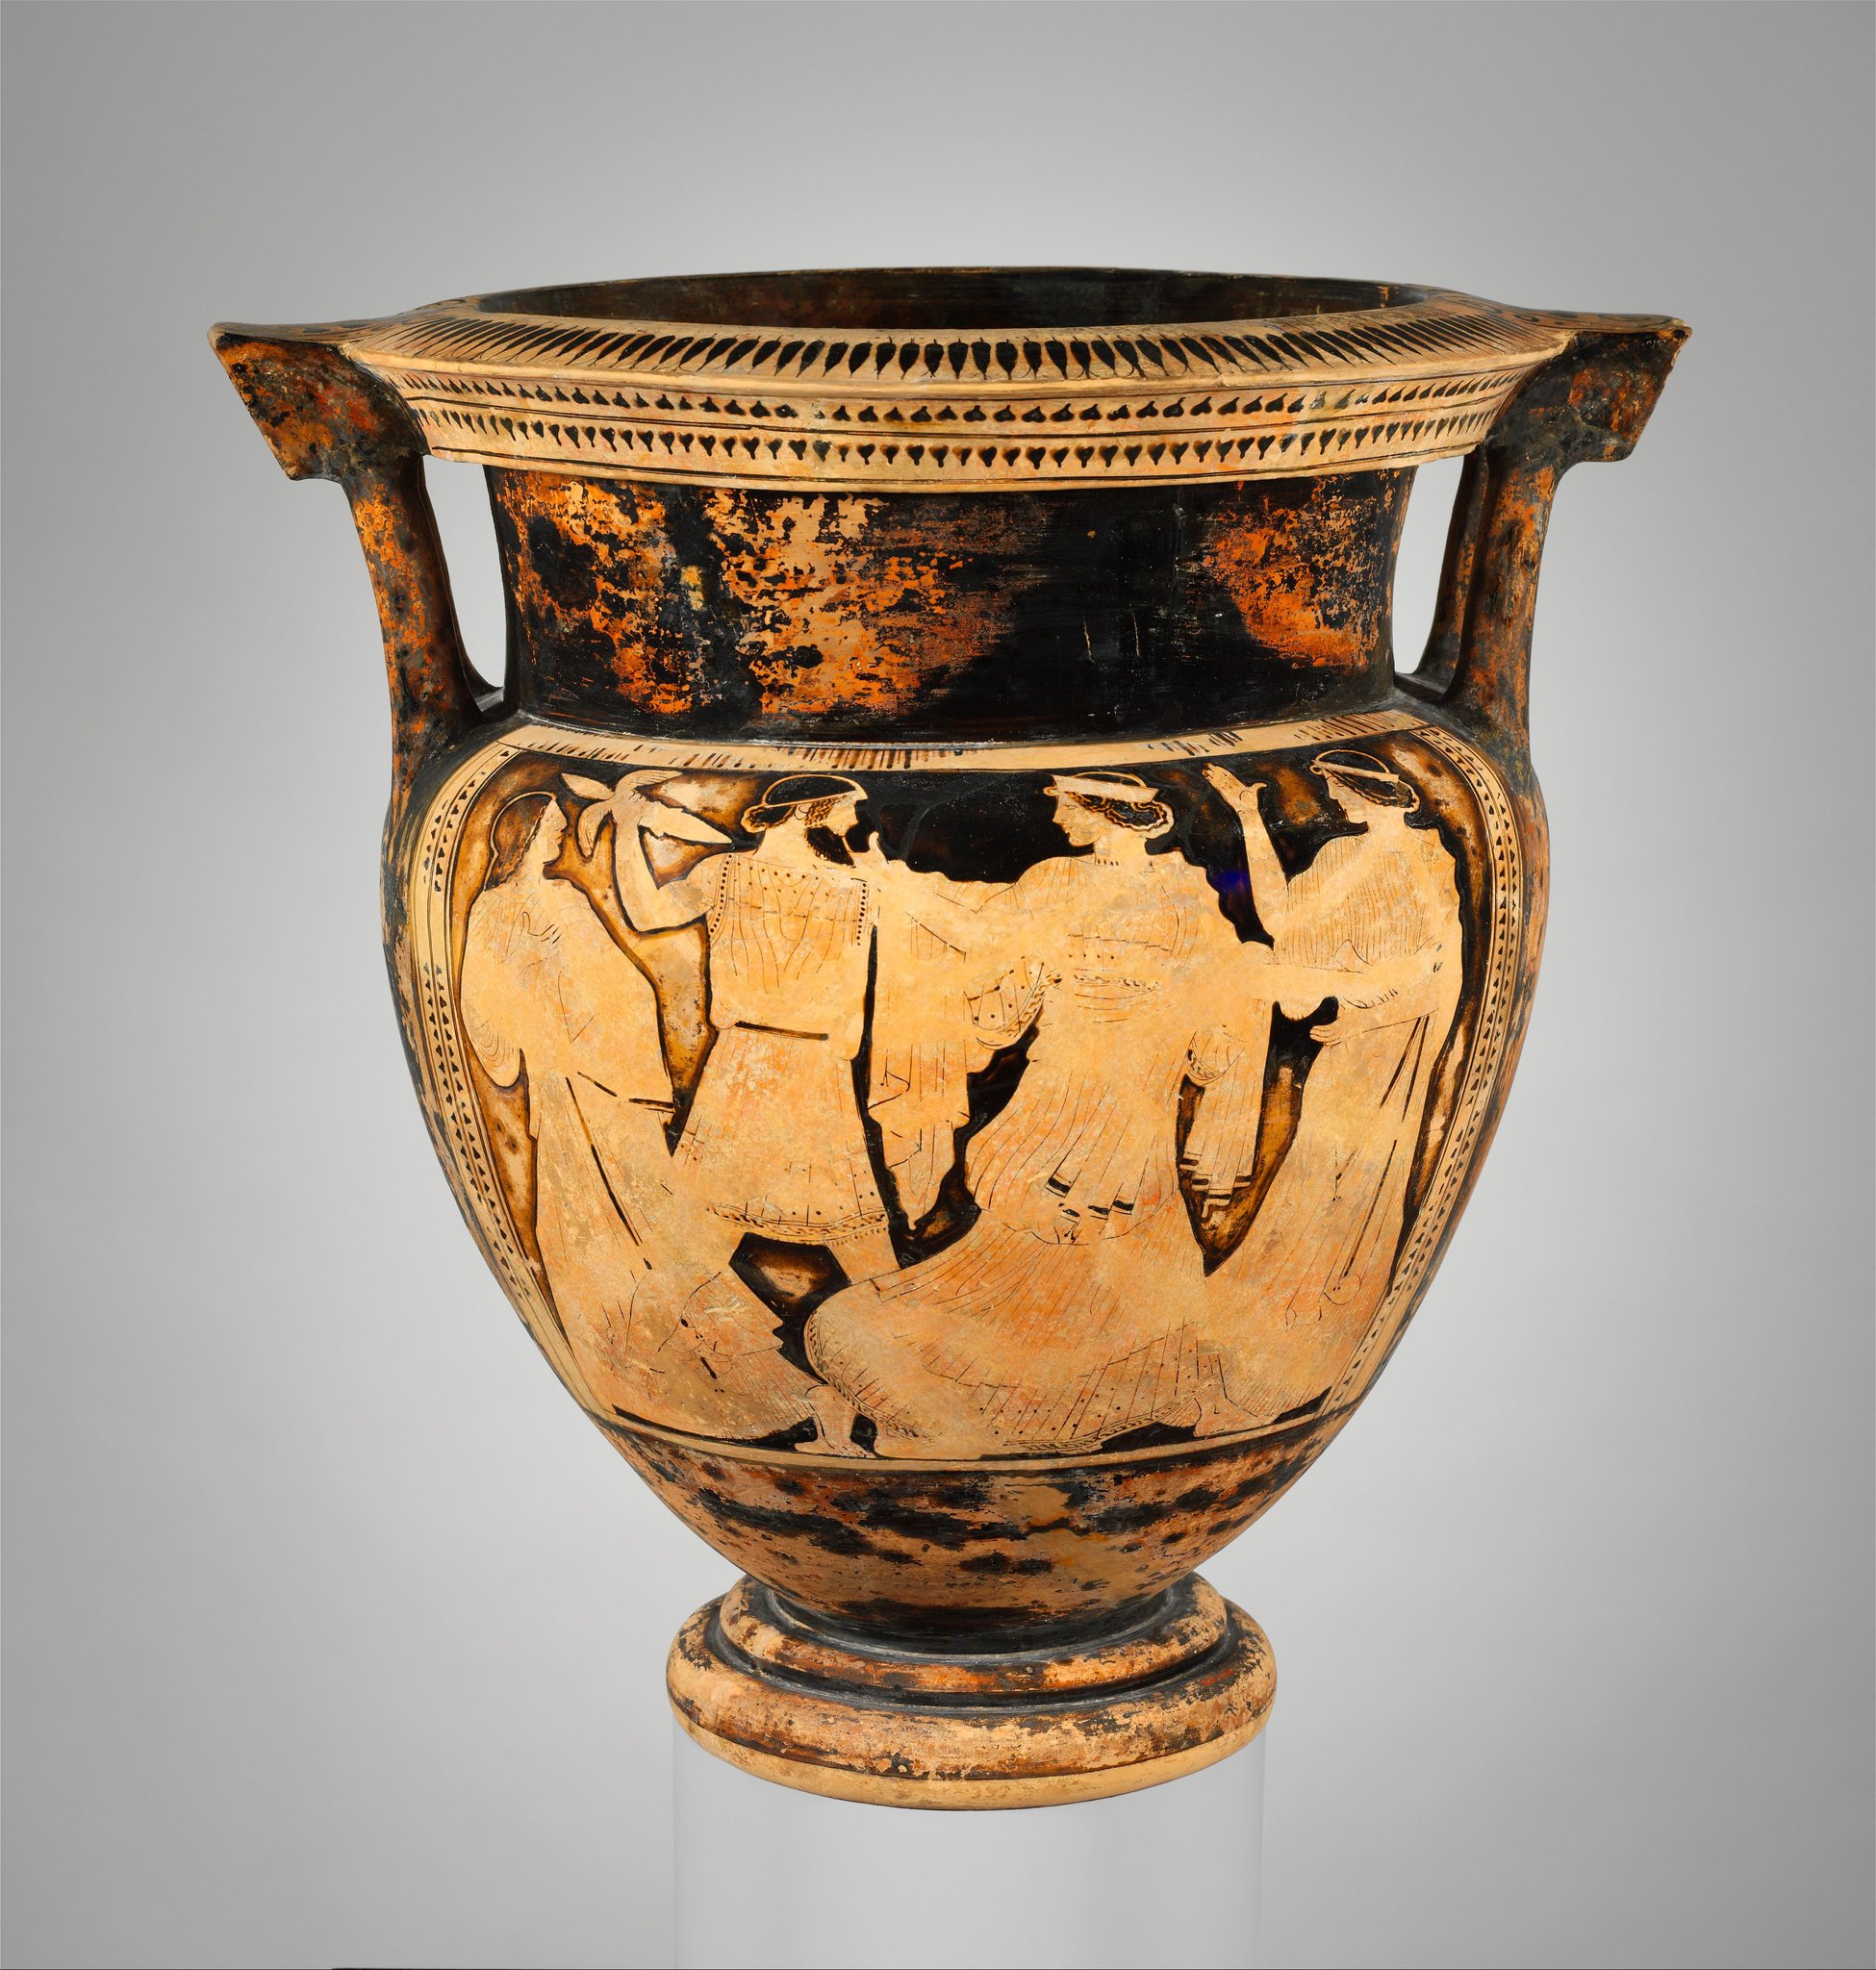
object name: column krater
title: Terracotta column-krater (vase for mixing wine and water)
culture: greek, attic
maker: boreas painter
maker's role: artist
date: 460 BCE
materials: terracotta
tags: women,zeus